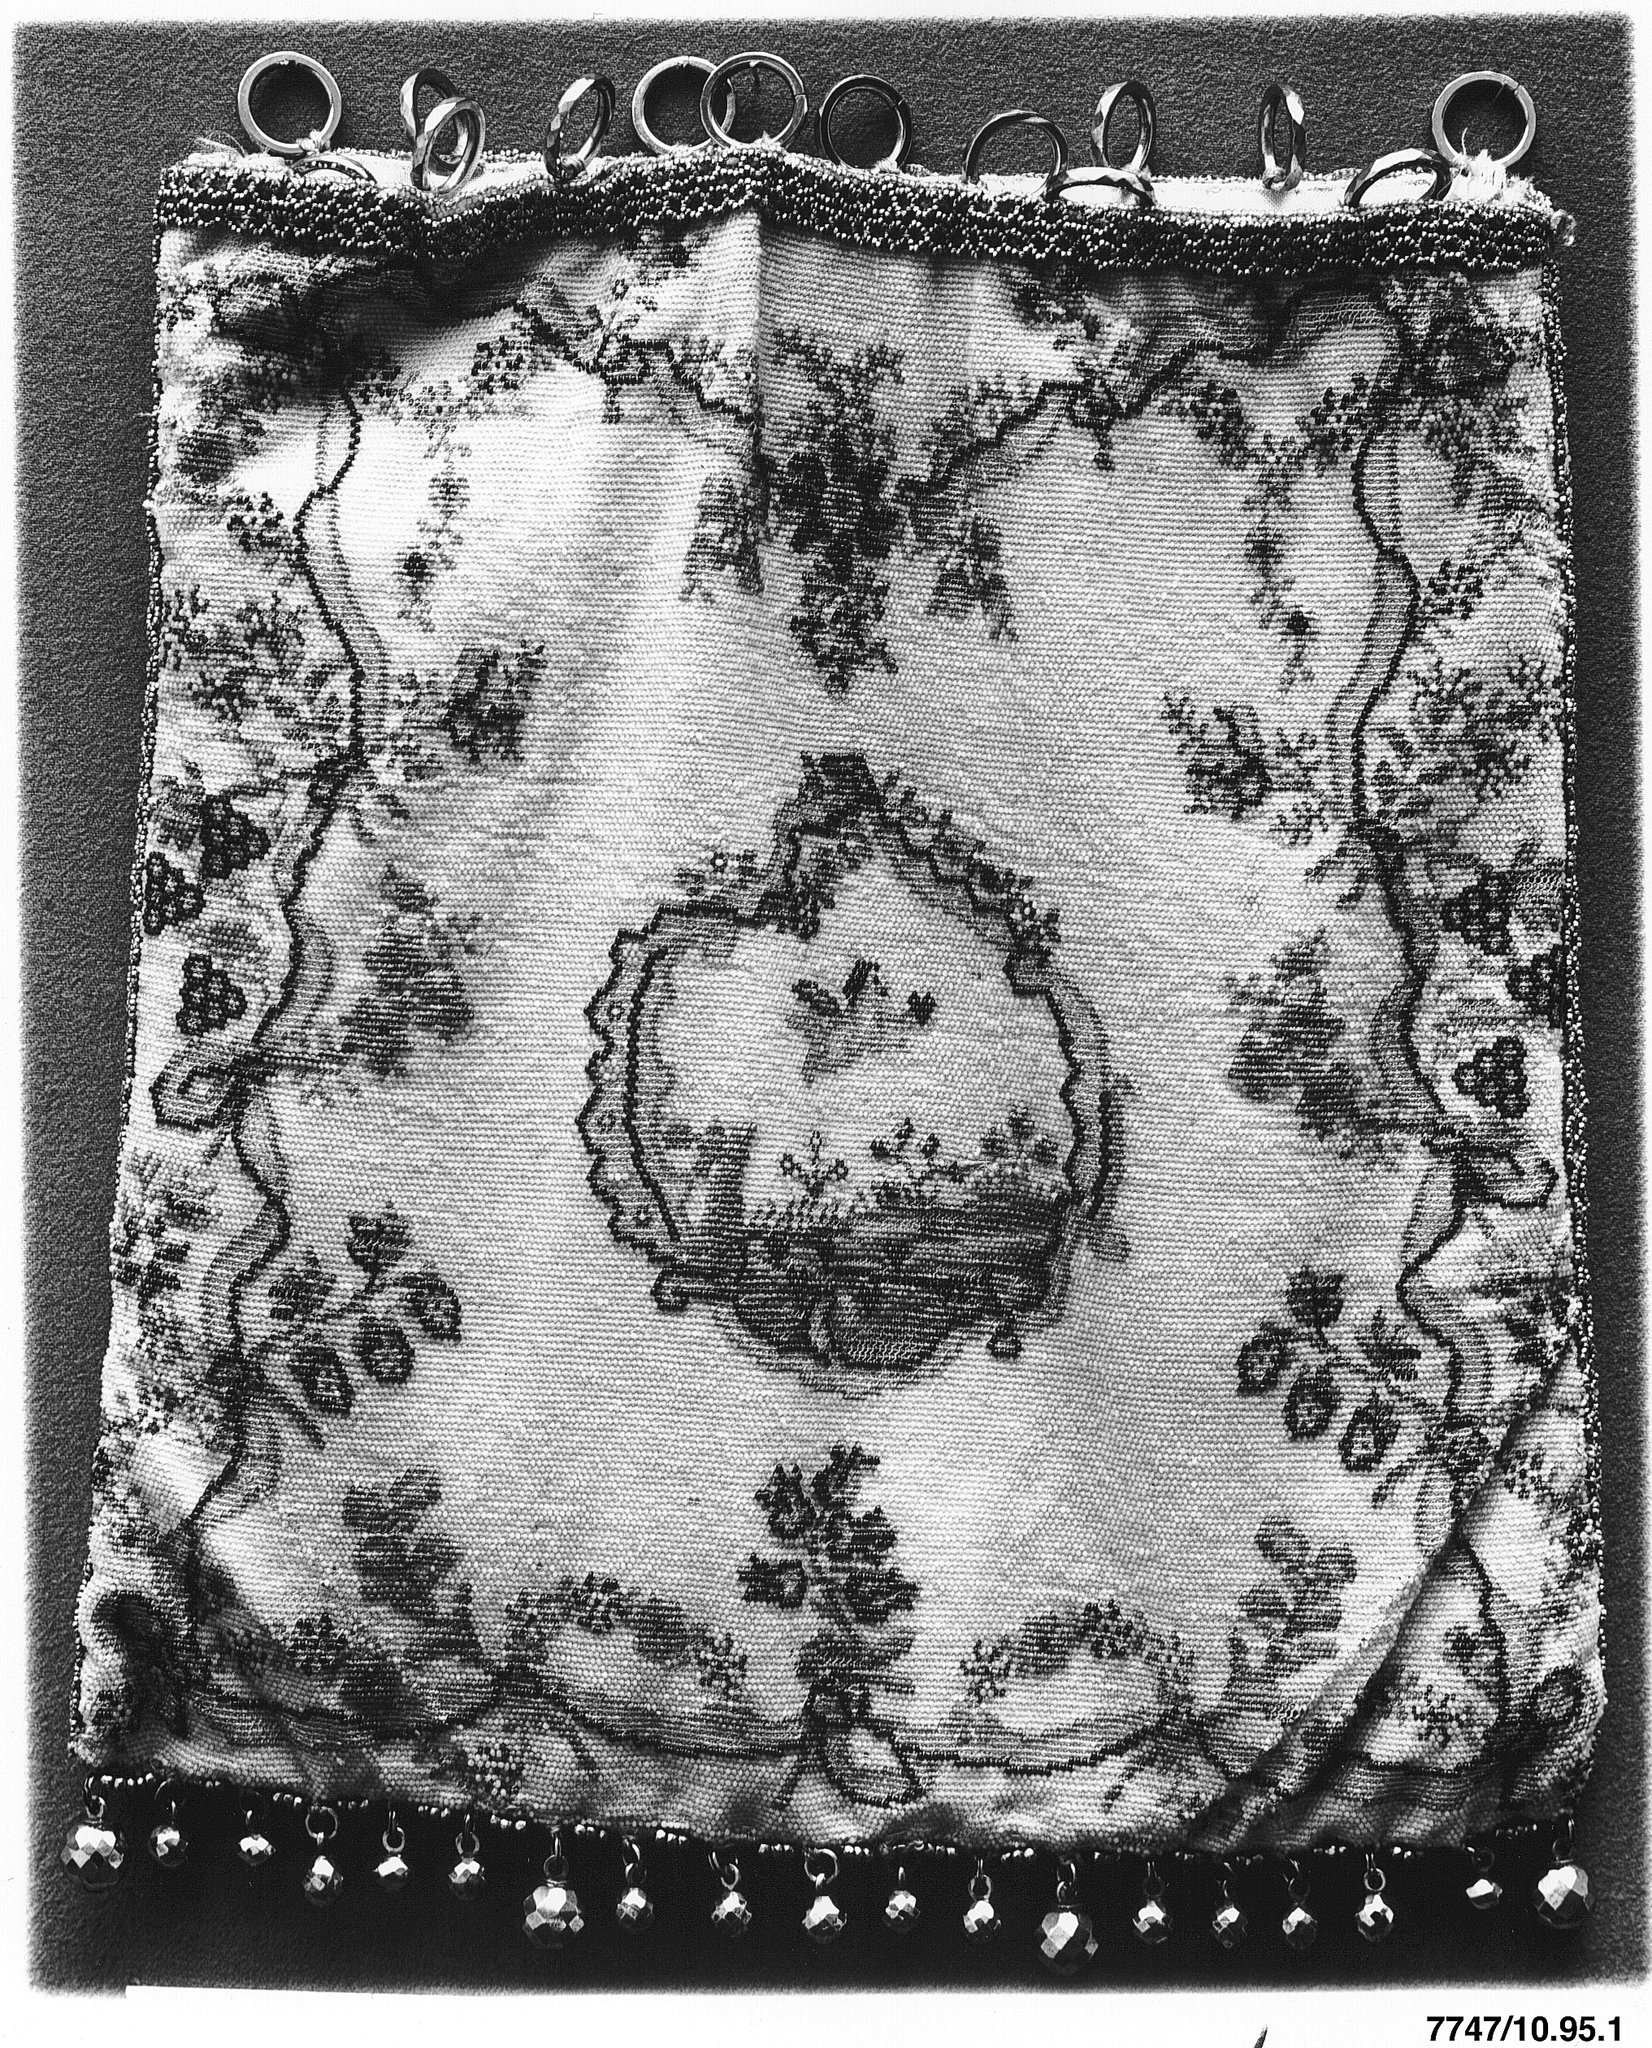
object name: bag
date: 1734-1766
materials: glass, silk, steel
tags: grapes,flowers